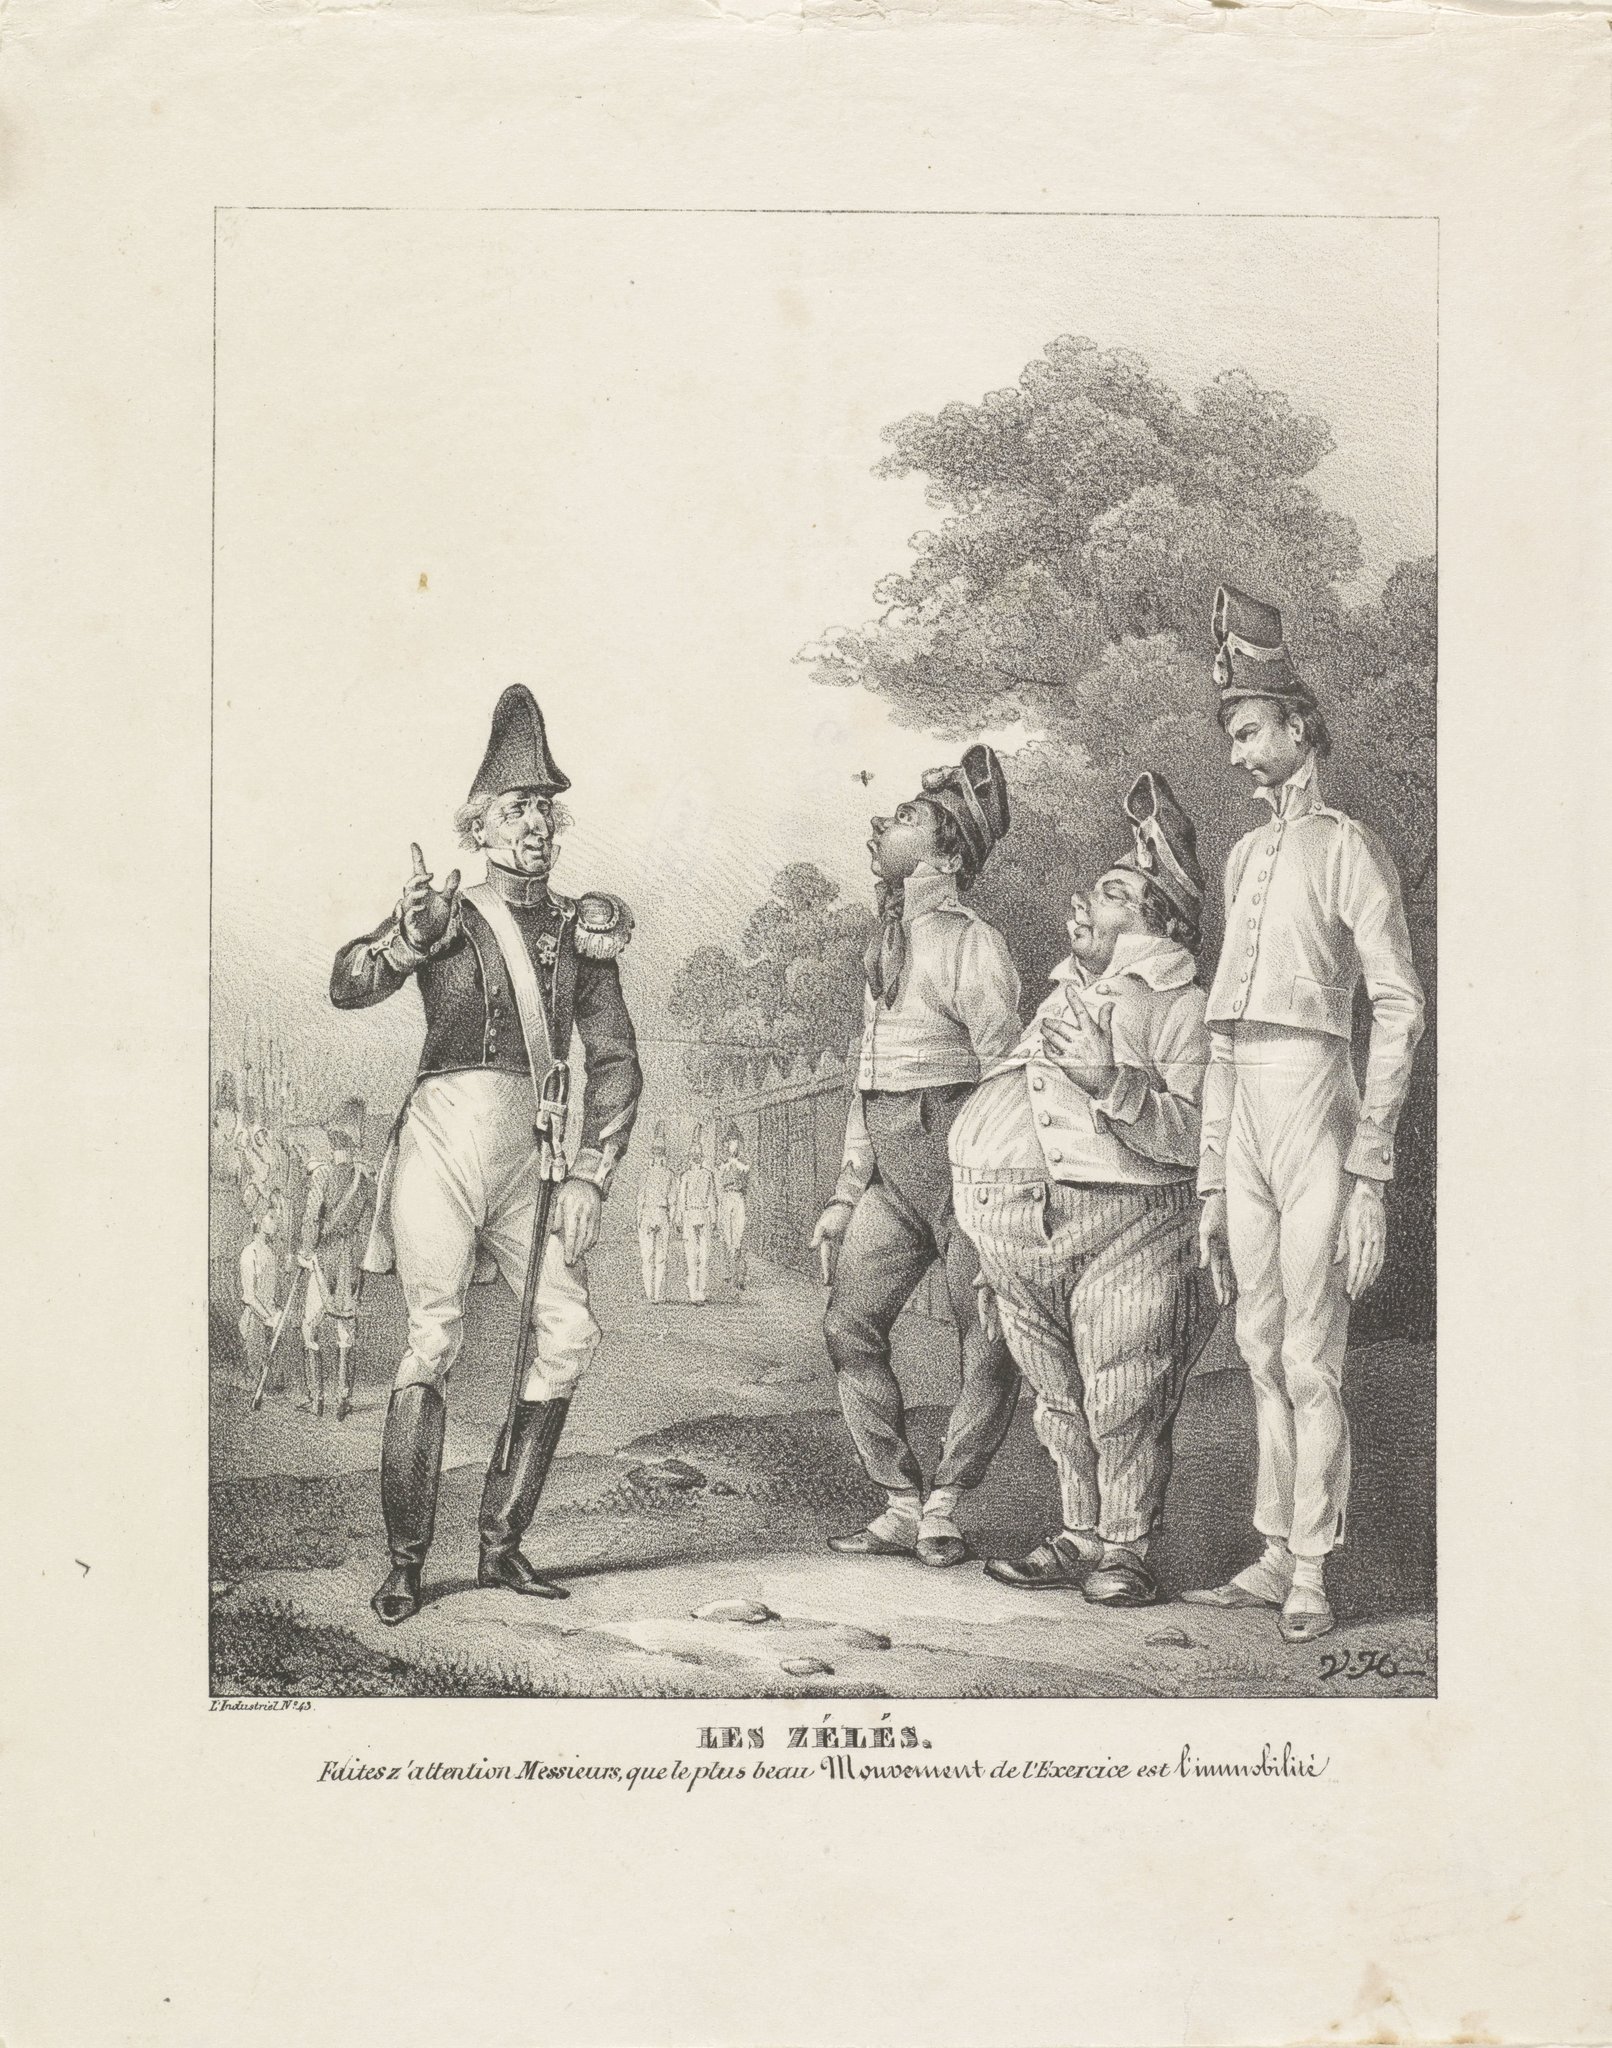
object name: cartoon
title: De fanatiekelingen, 1828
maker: jean-louis van hemelryck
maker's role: print maker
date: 1828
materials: paper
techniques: lithograph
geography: southern netherlands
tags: the soldier; the soldier's life, belgium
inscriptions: collector's mark: Lugt 2228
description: Een oude officier instrueert een groep van drie nieuwelingen. Onderdeel van een serie van ca. 24 spotprenten uit 1828 op de wanverhoudingen binnen de Belgische schutterijen door de maatschappelijke ongelijkheid binnen het korps, na de reorganisatie ingevoerd op 11 april 1827.